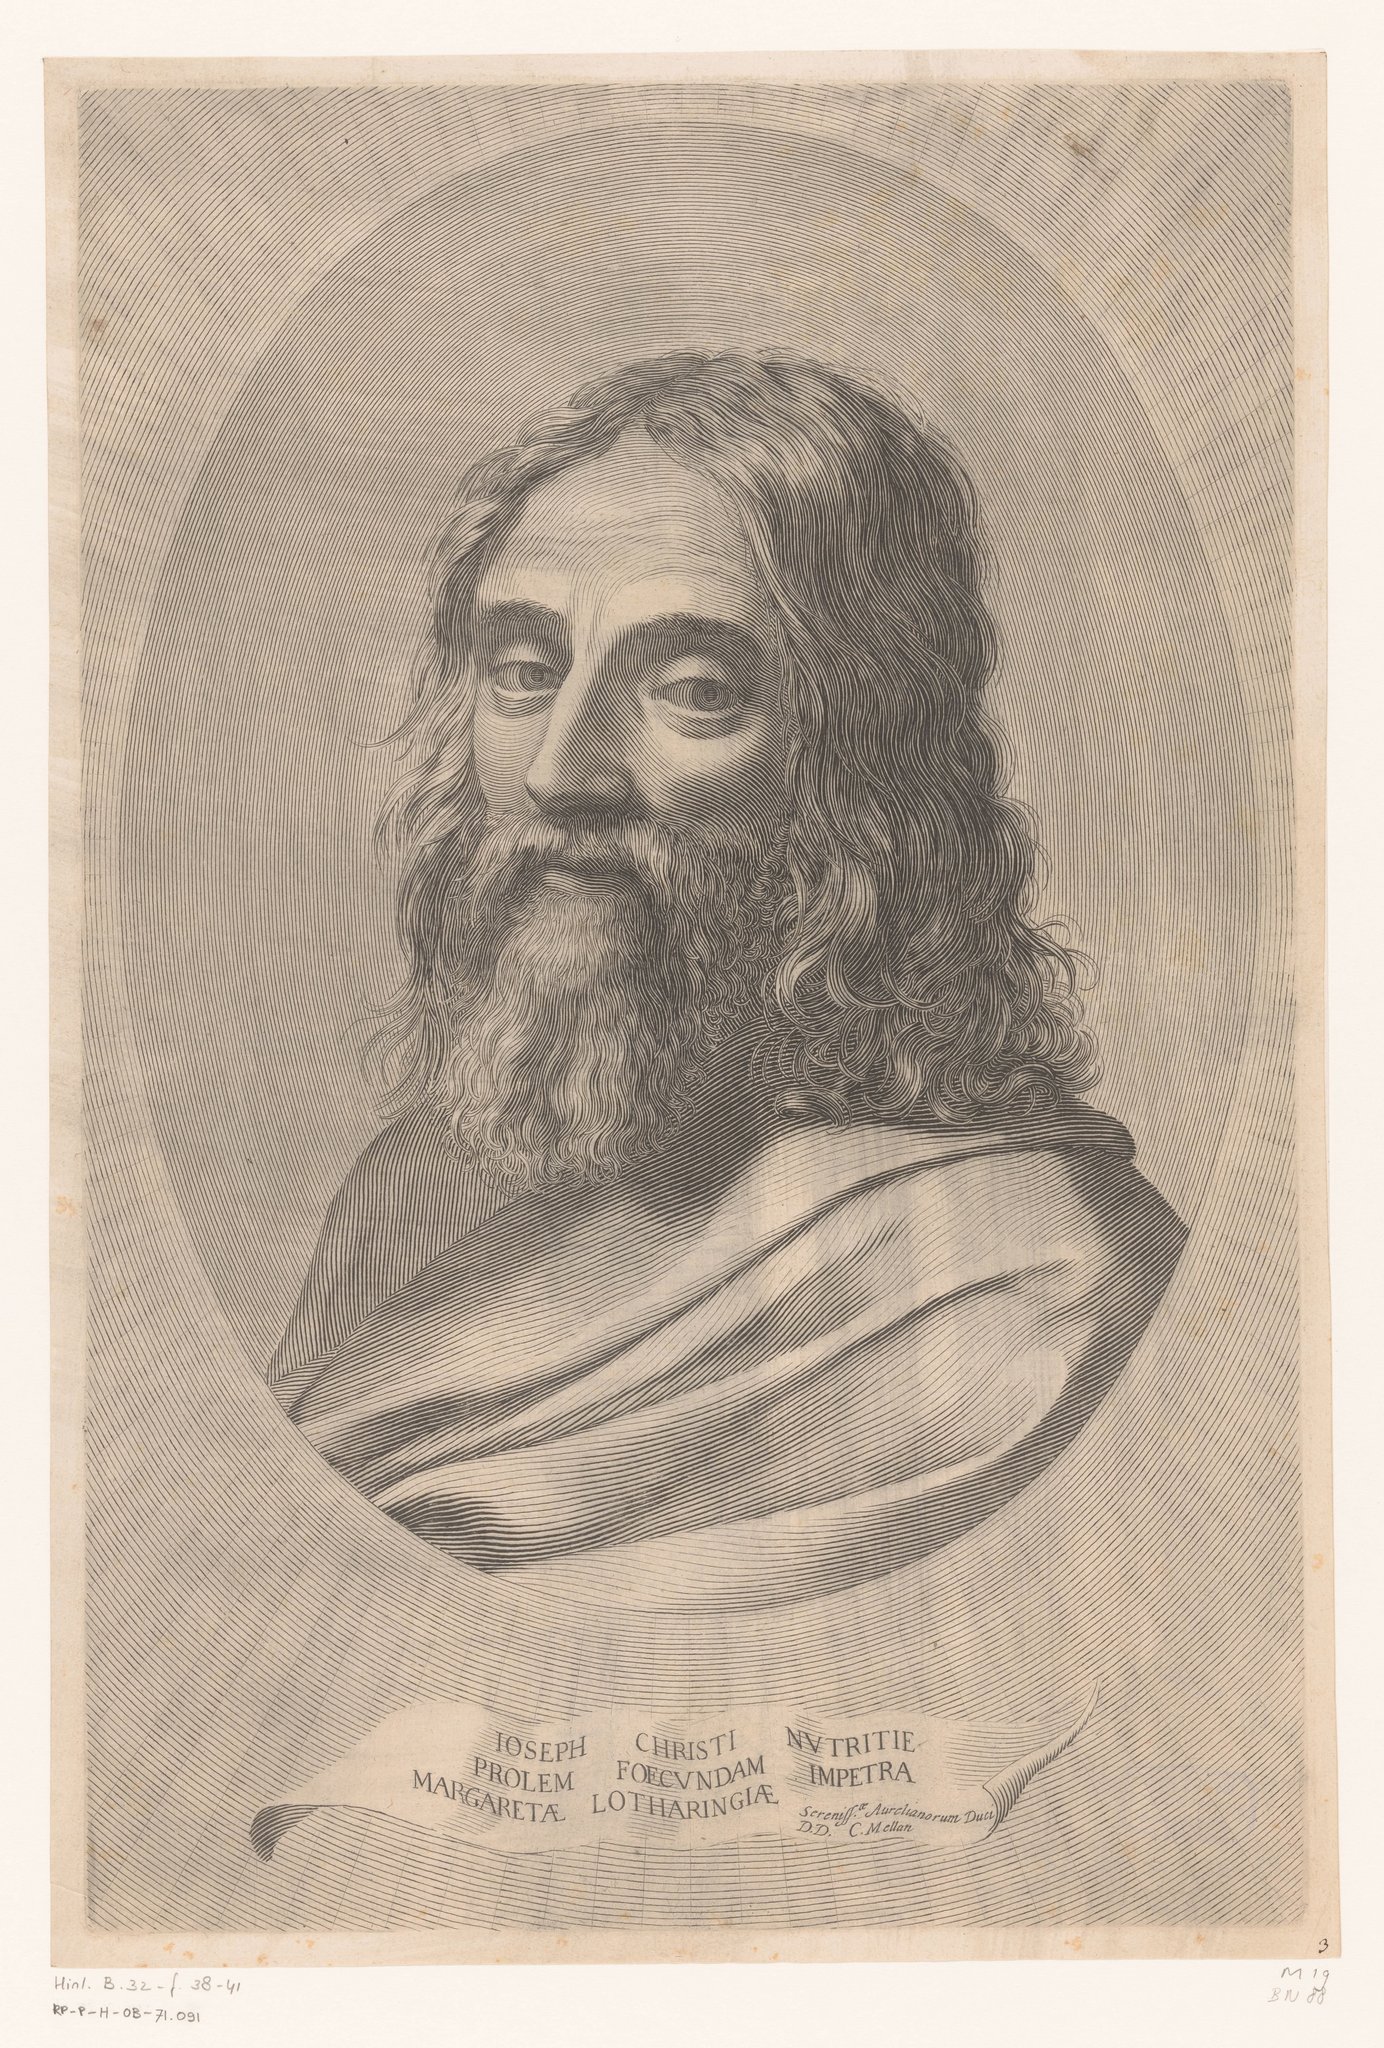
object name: print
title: H. Jozef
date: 1608-1672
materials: paper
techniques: engraving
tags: the foster-father of christ, joseph of nazareth, husband of mary; possible attributes: flowering rod or wand, lily, carpenter's tools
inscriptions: collector's mark: Lugt 11, number: ‘3’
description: Volgens IFF 17e siècle, p. 74 zou dit een pendant zijn van cat. nrs. 17 en 30: respectievelijk een bustes van Christus en Maria. Mogelijk werden eerder cat. nrs. 16 en 31 bedoeld. Dit betreffen eveneens bustes van Christus en Maria, maar deze bustes in ovalen worden omringd door dezelfde stralen en een inscriptie op een banderol.